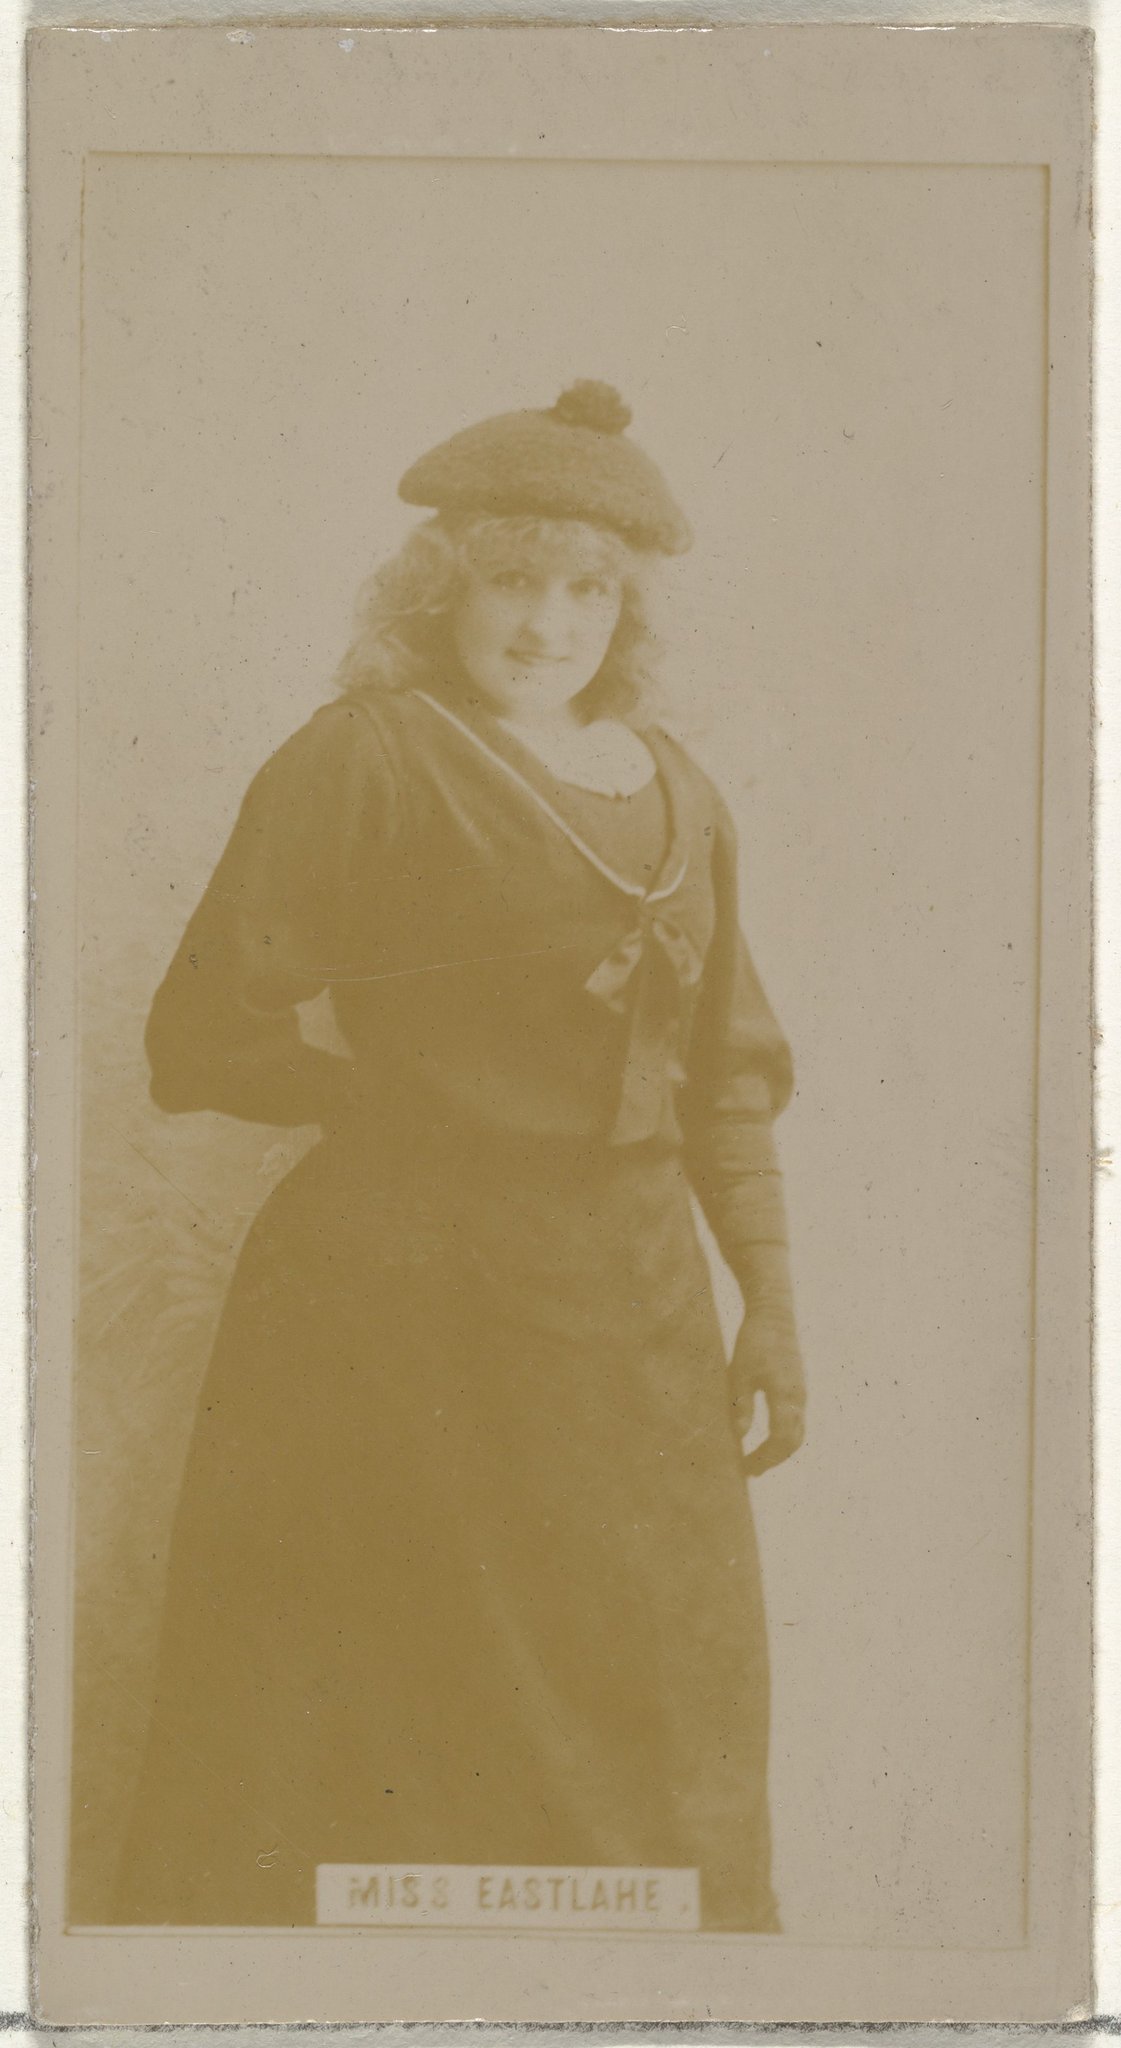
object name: photograph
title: Miss Eastlake, from the Actors and Actresses series (N145-8) issued by Duke Sons & Co. to promote Duke Cigarettes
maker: w. duke, sons & co.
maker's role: publisher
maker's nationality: american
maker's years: 1870-1920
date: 1891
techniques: albumen silver print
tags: portraits,women,actresses